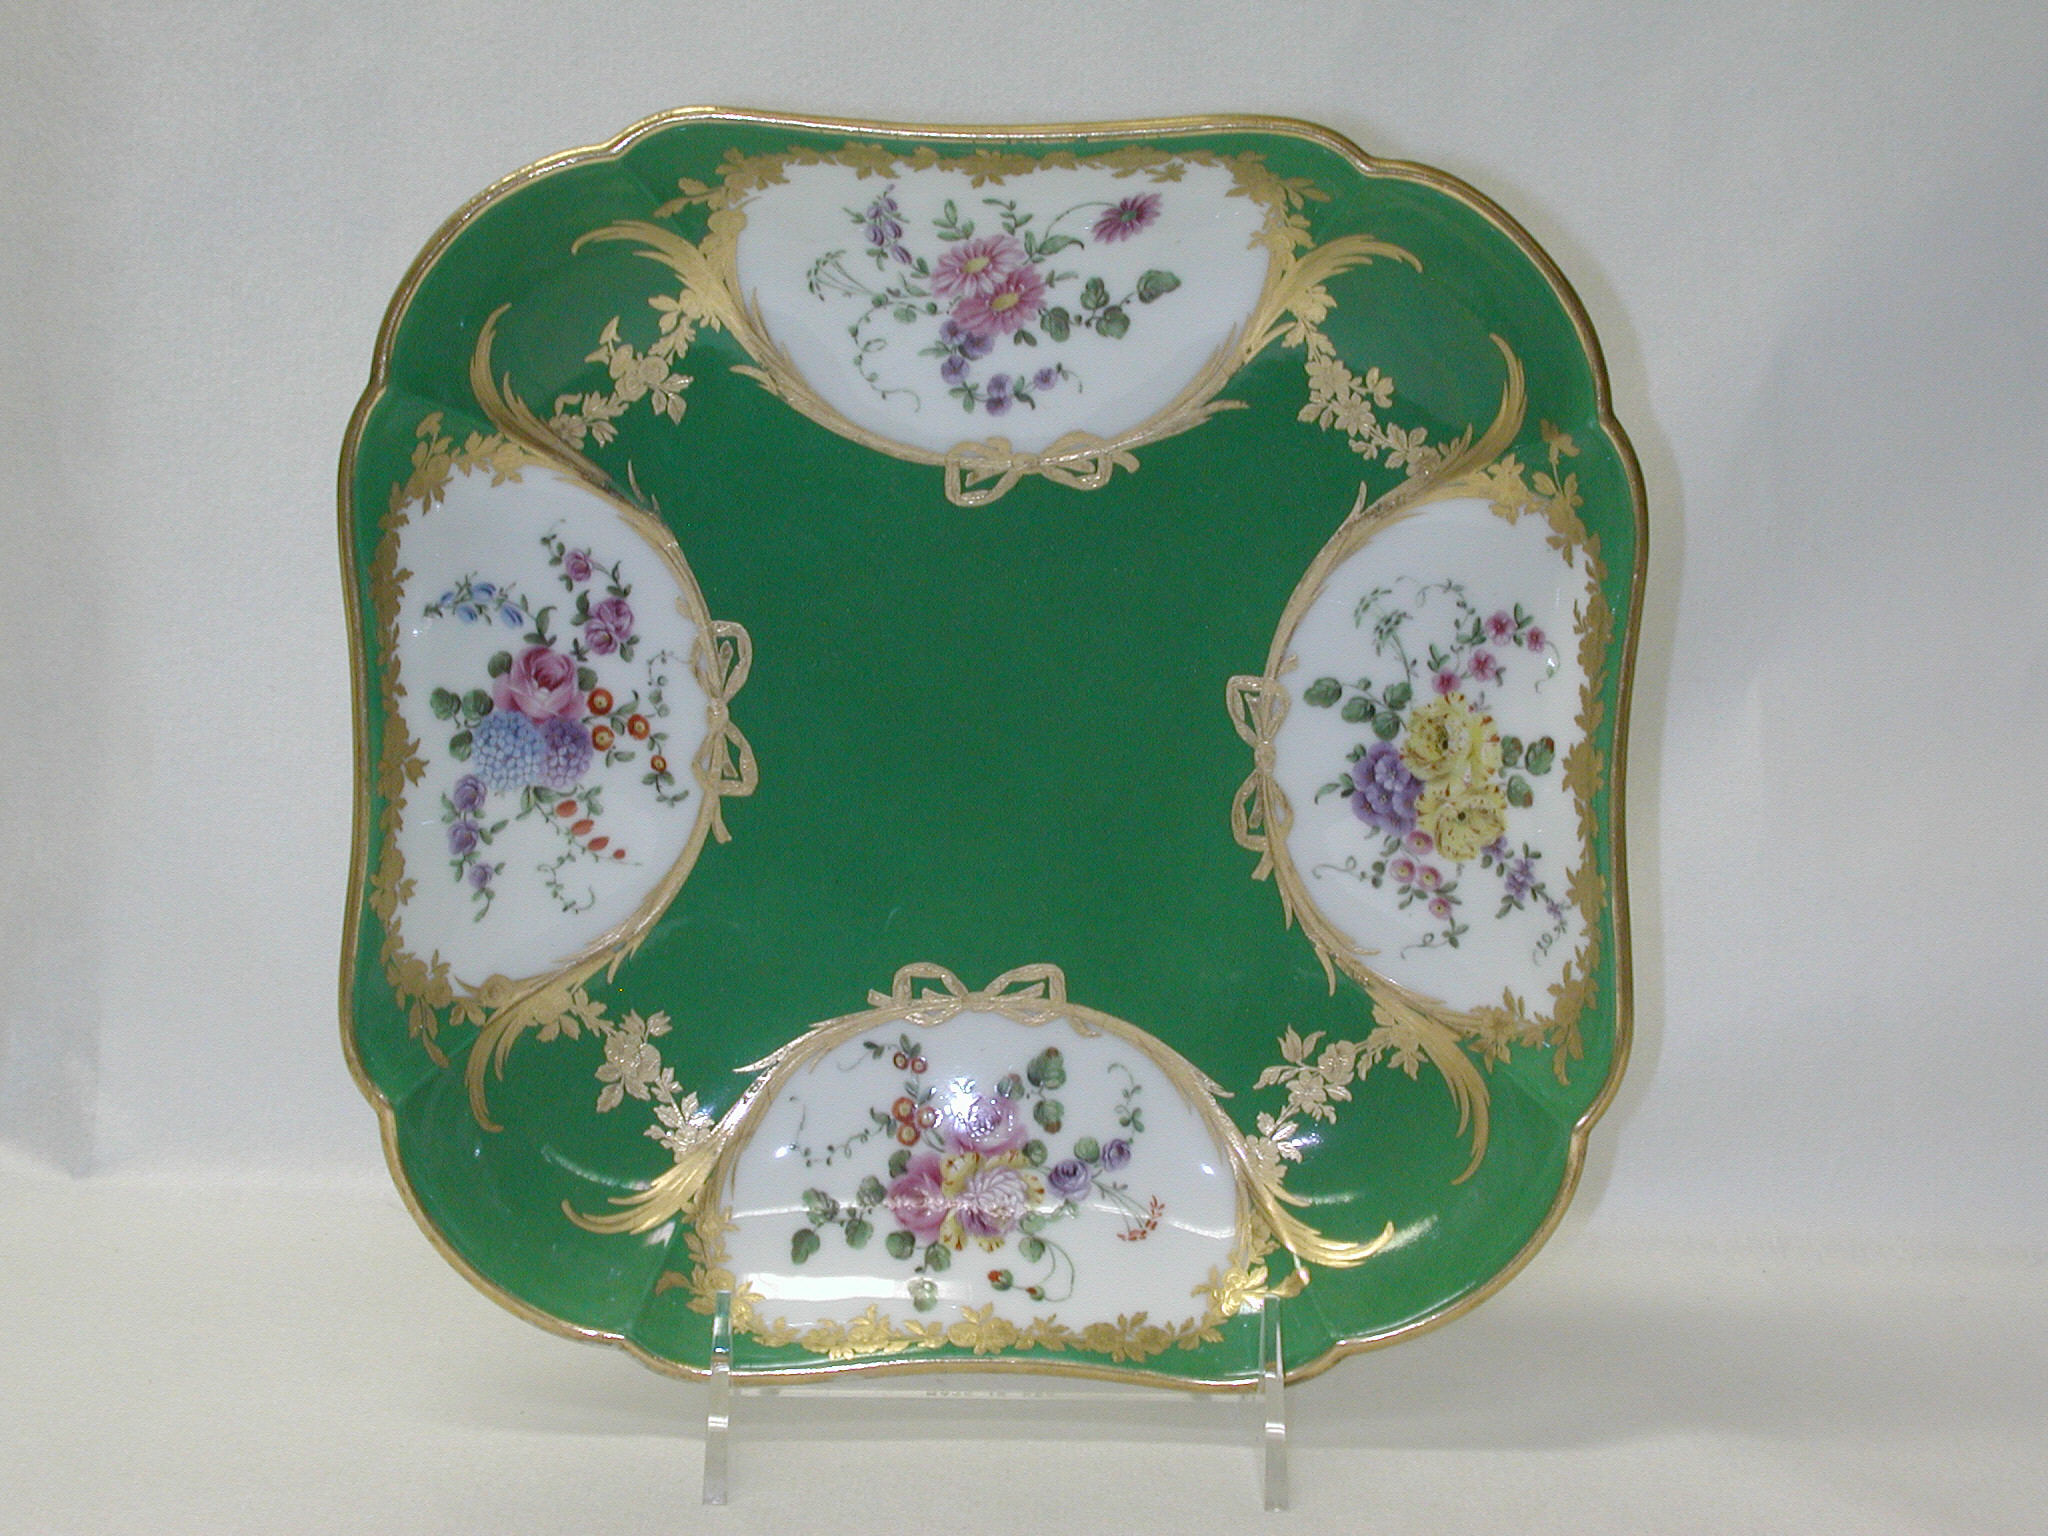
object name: fruit dish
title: Fruit dish (part of a service)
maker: sèvres manufactory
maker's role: manufactory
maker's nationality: french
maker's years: 1740-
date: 1772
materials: hard paste porcelain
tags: flowers